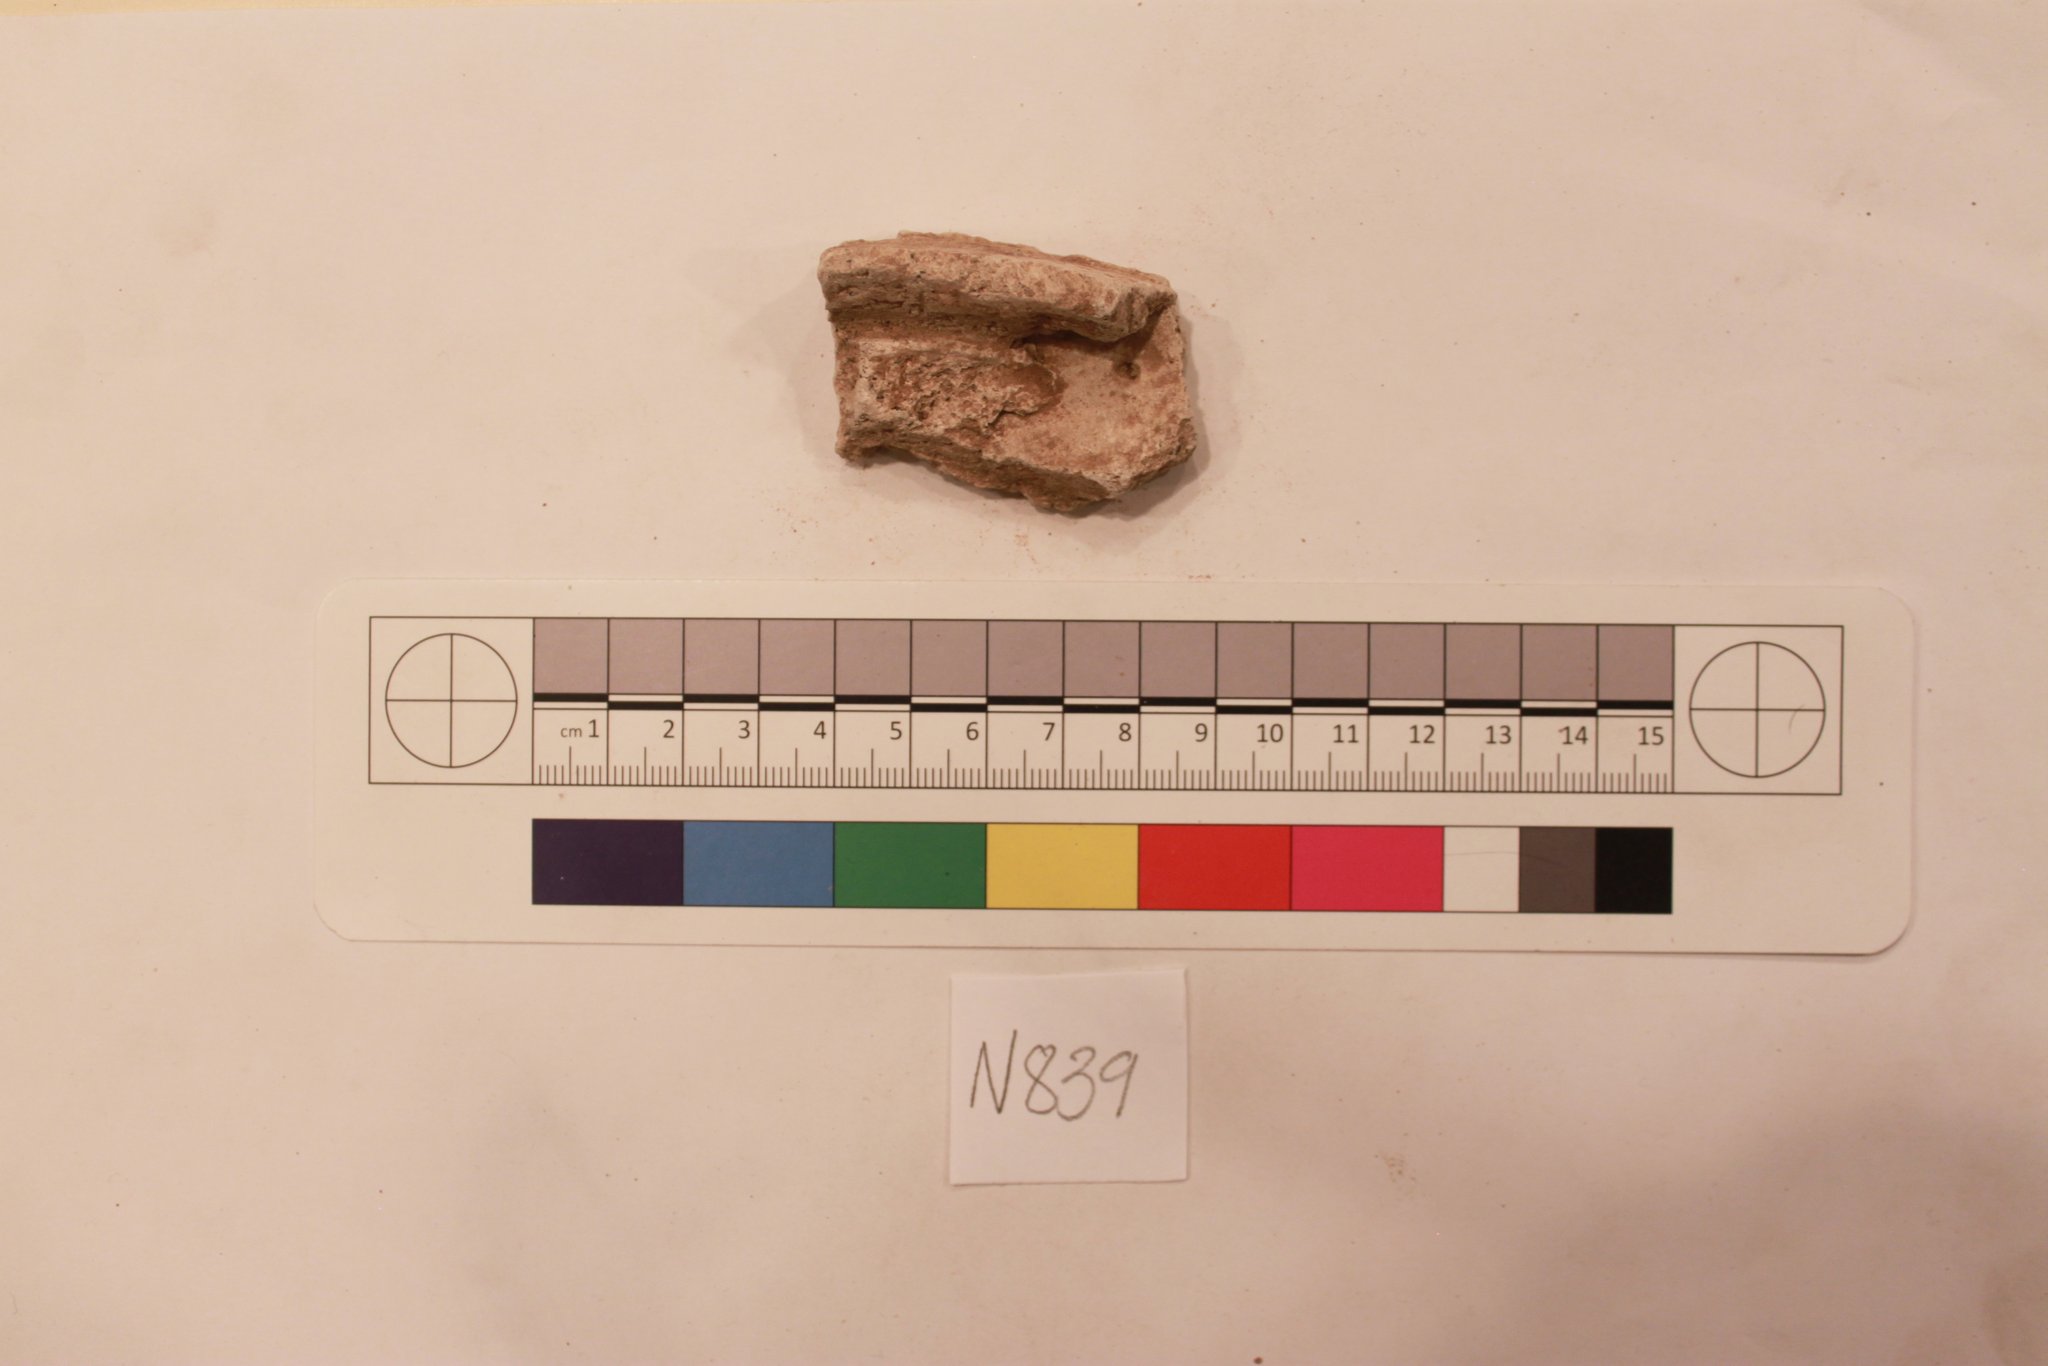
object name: fragment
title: Stucco Fragment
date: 701-1200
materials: plaster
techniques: carving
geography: iran